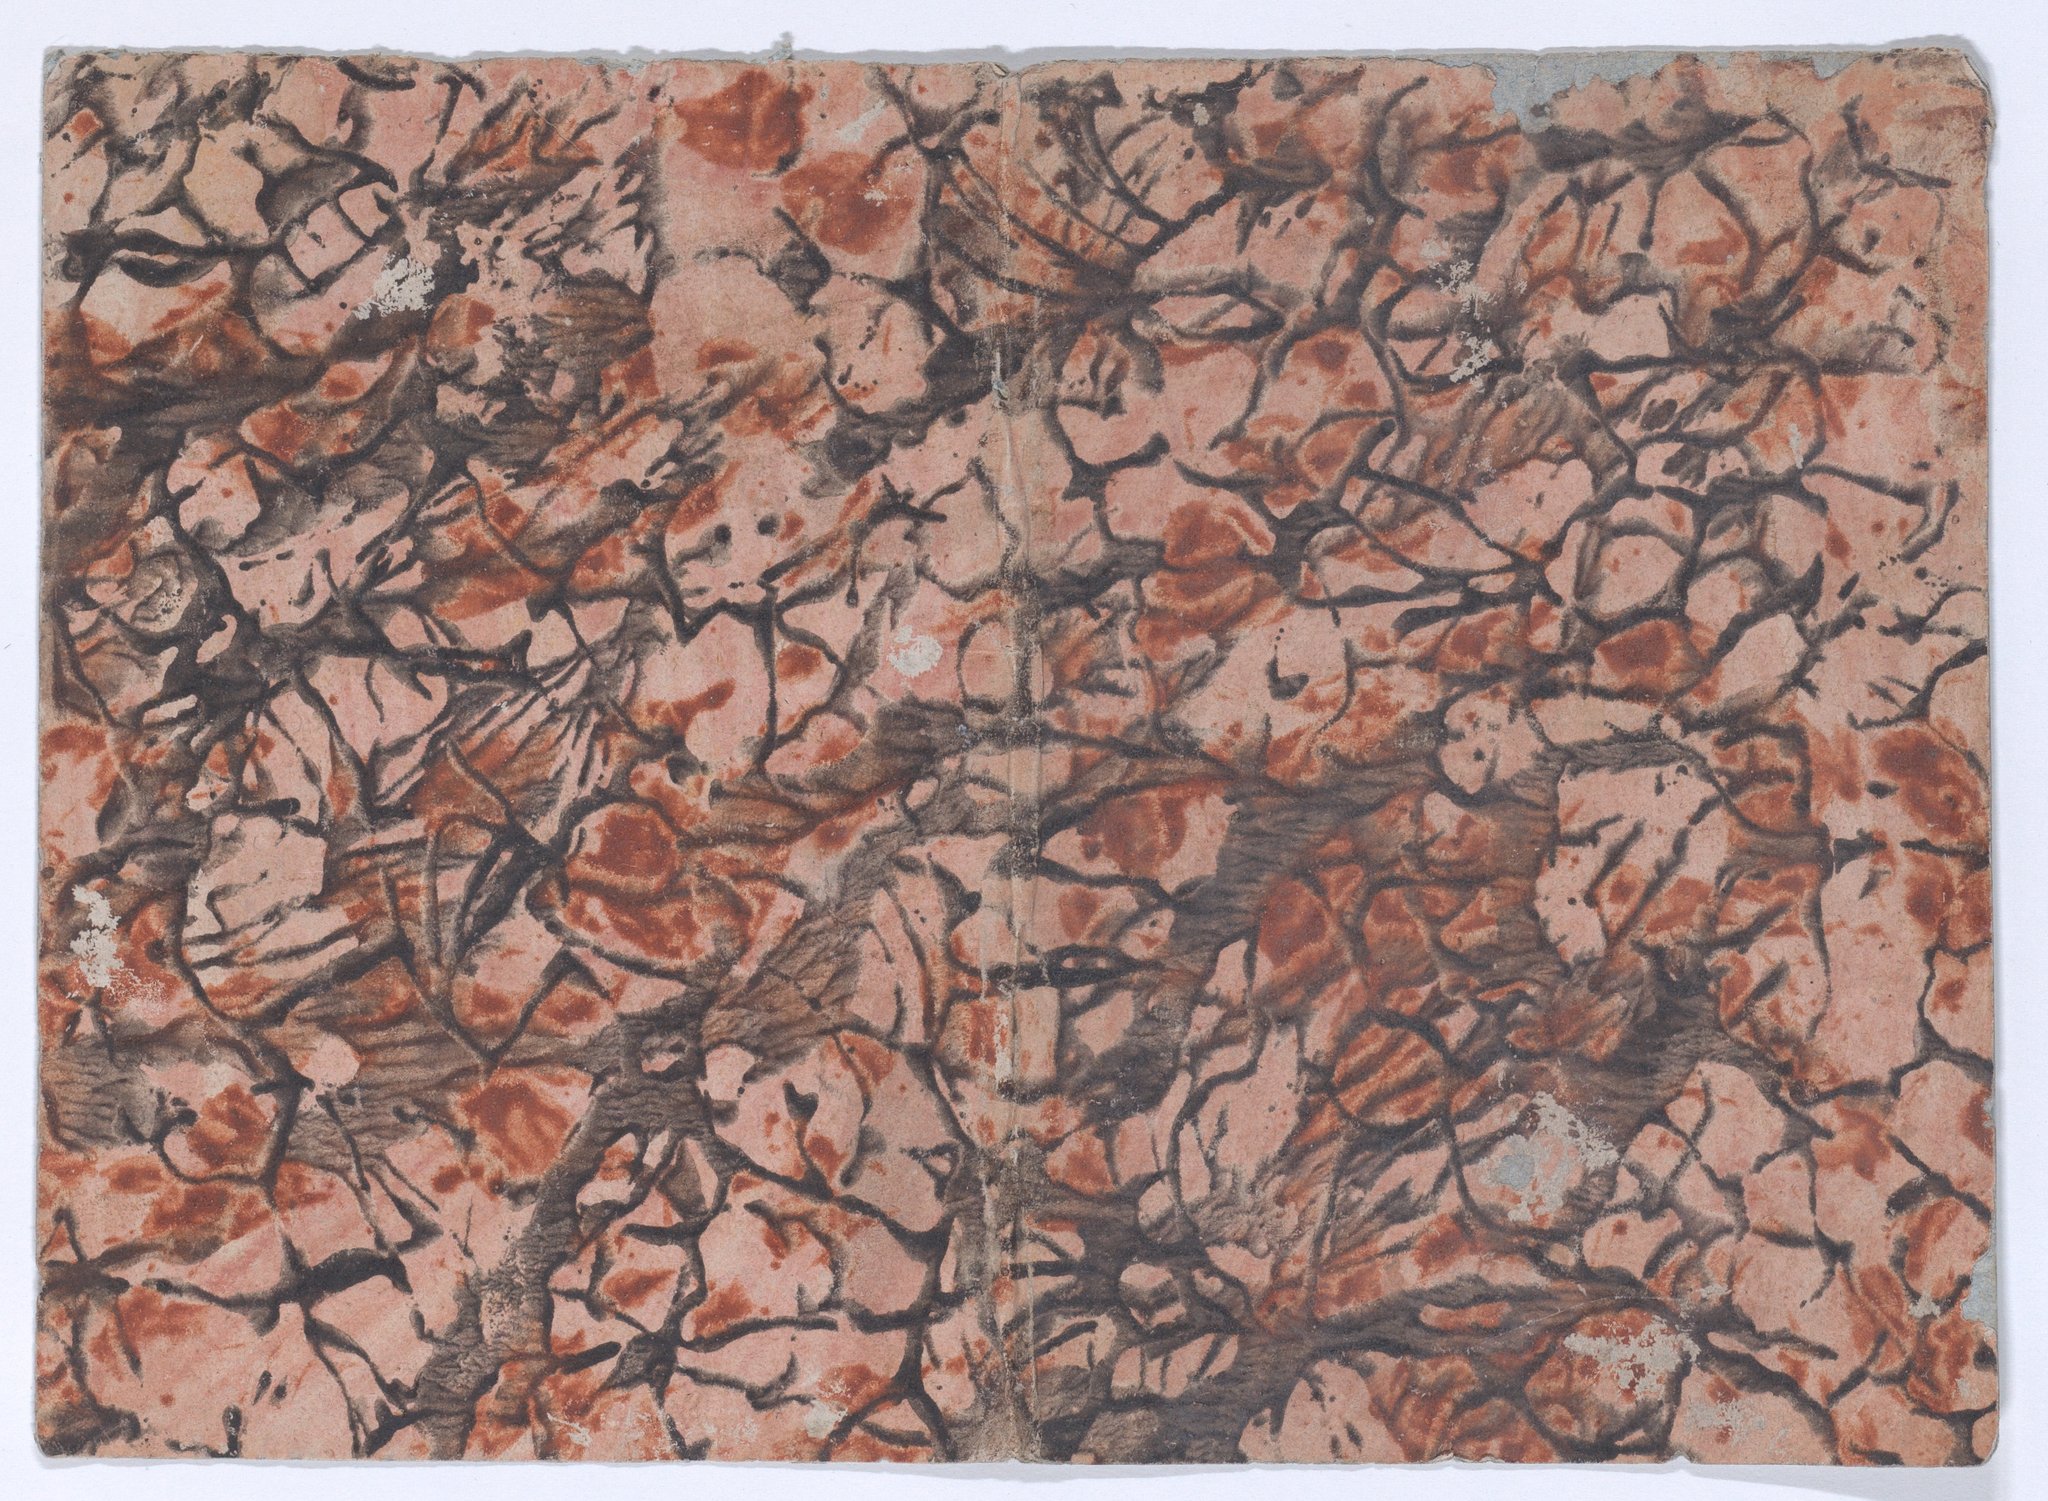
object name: print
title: Book cover with marbled pattern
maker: Anonymous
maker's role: artist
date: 1801-1900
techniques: relief print